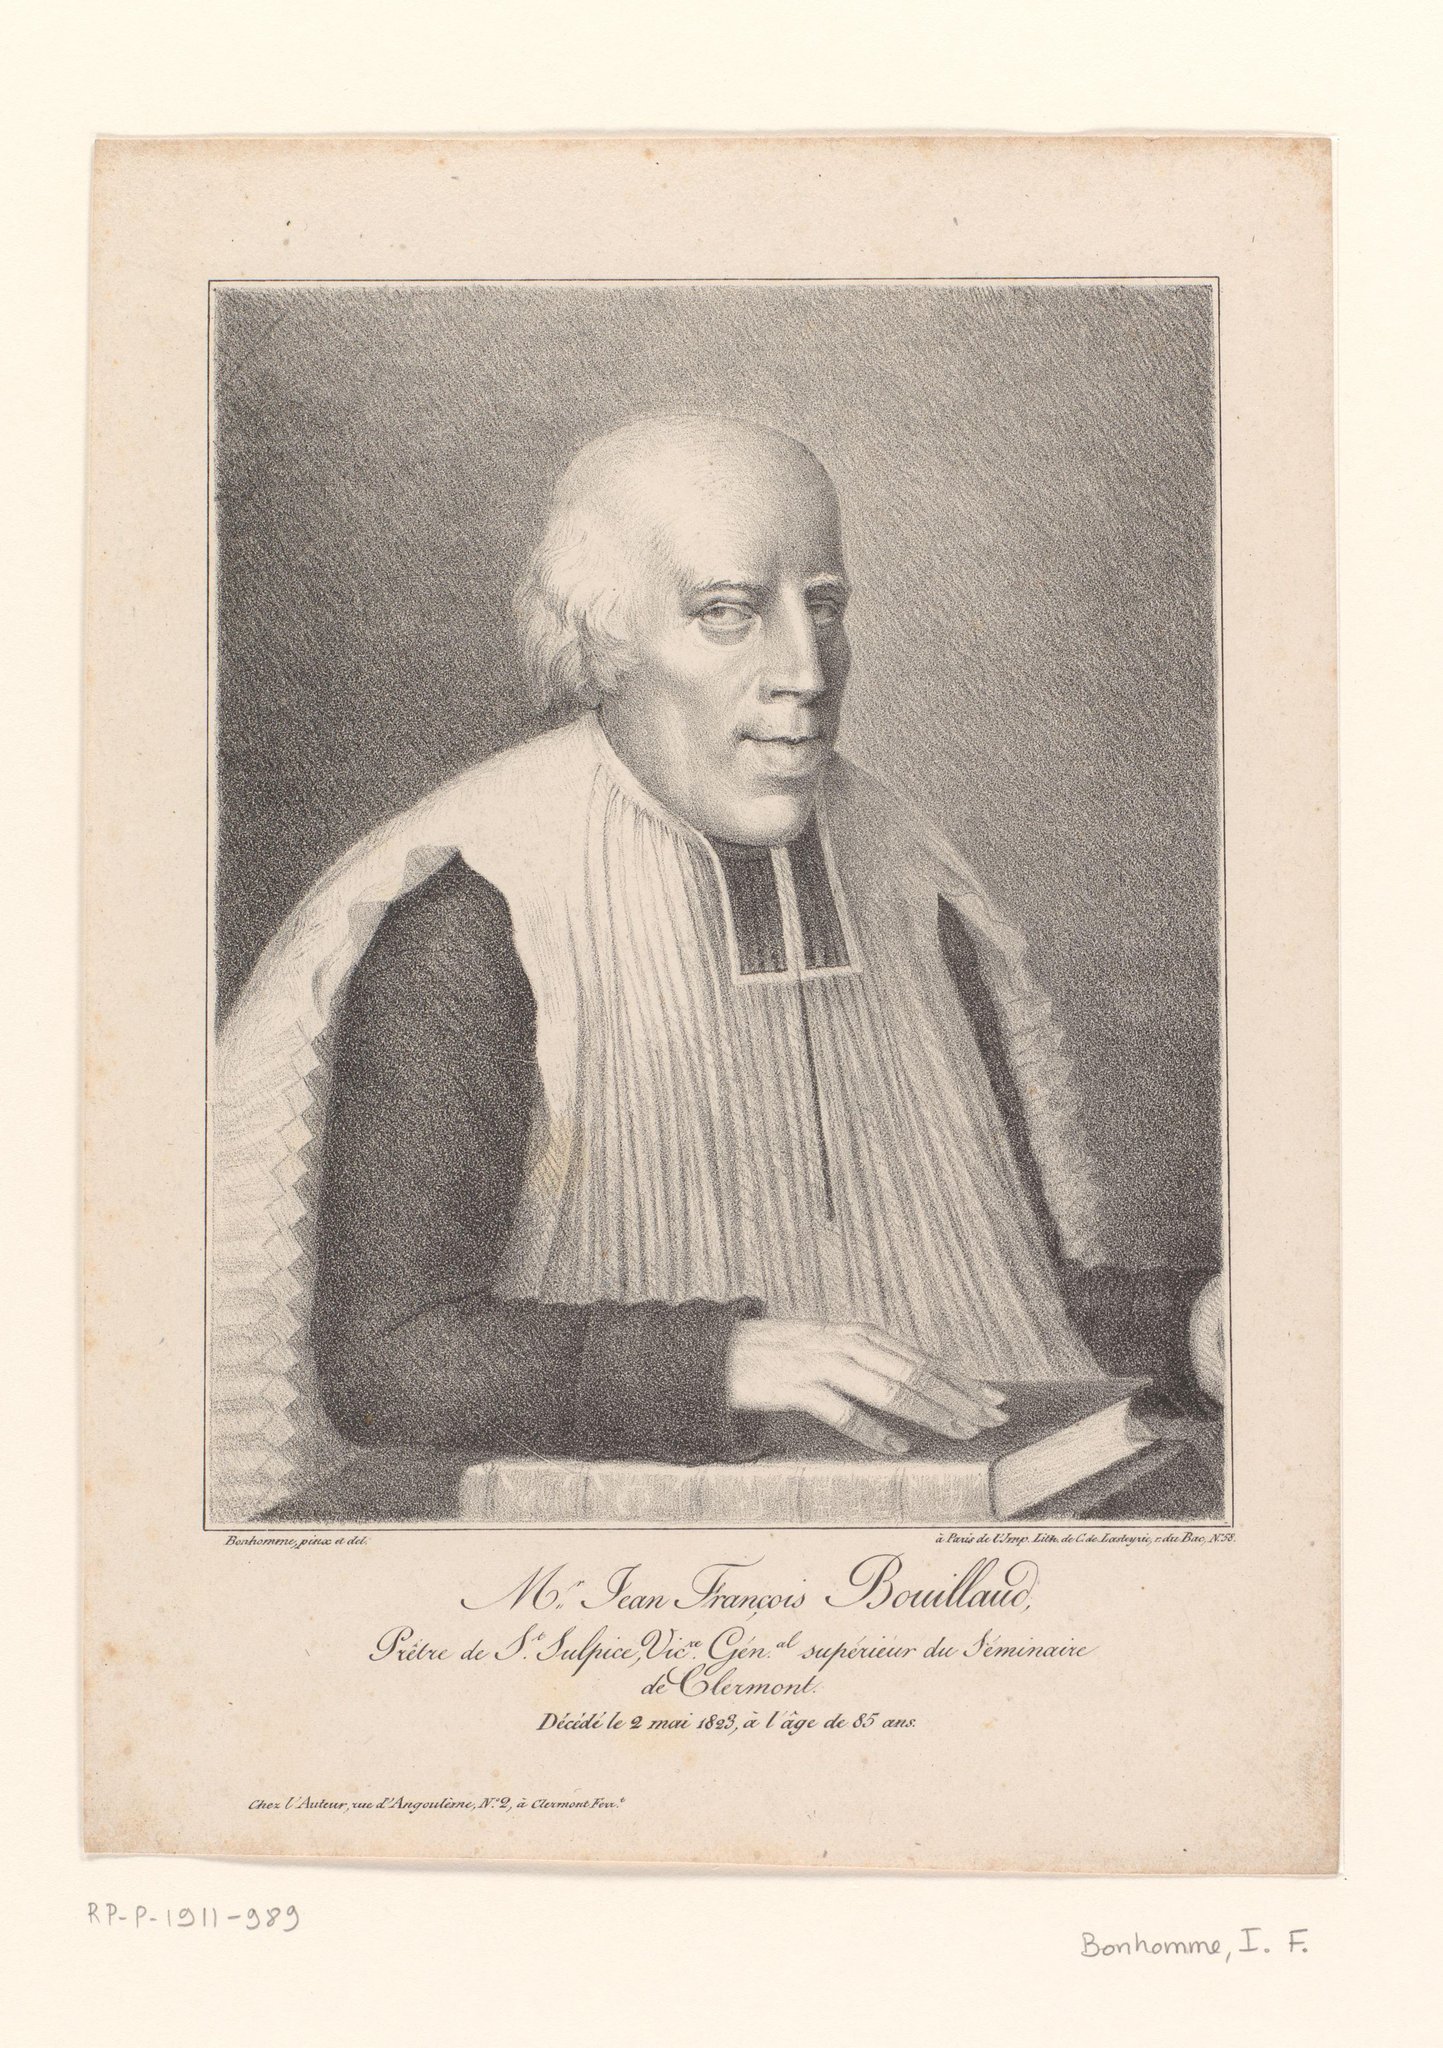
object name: print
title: Portret van de priester Jean-François Bouillaud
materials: paper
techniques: lithograph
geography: paris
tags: historical persons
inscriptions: collector's mark: Lugt 2228a